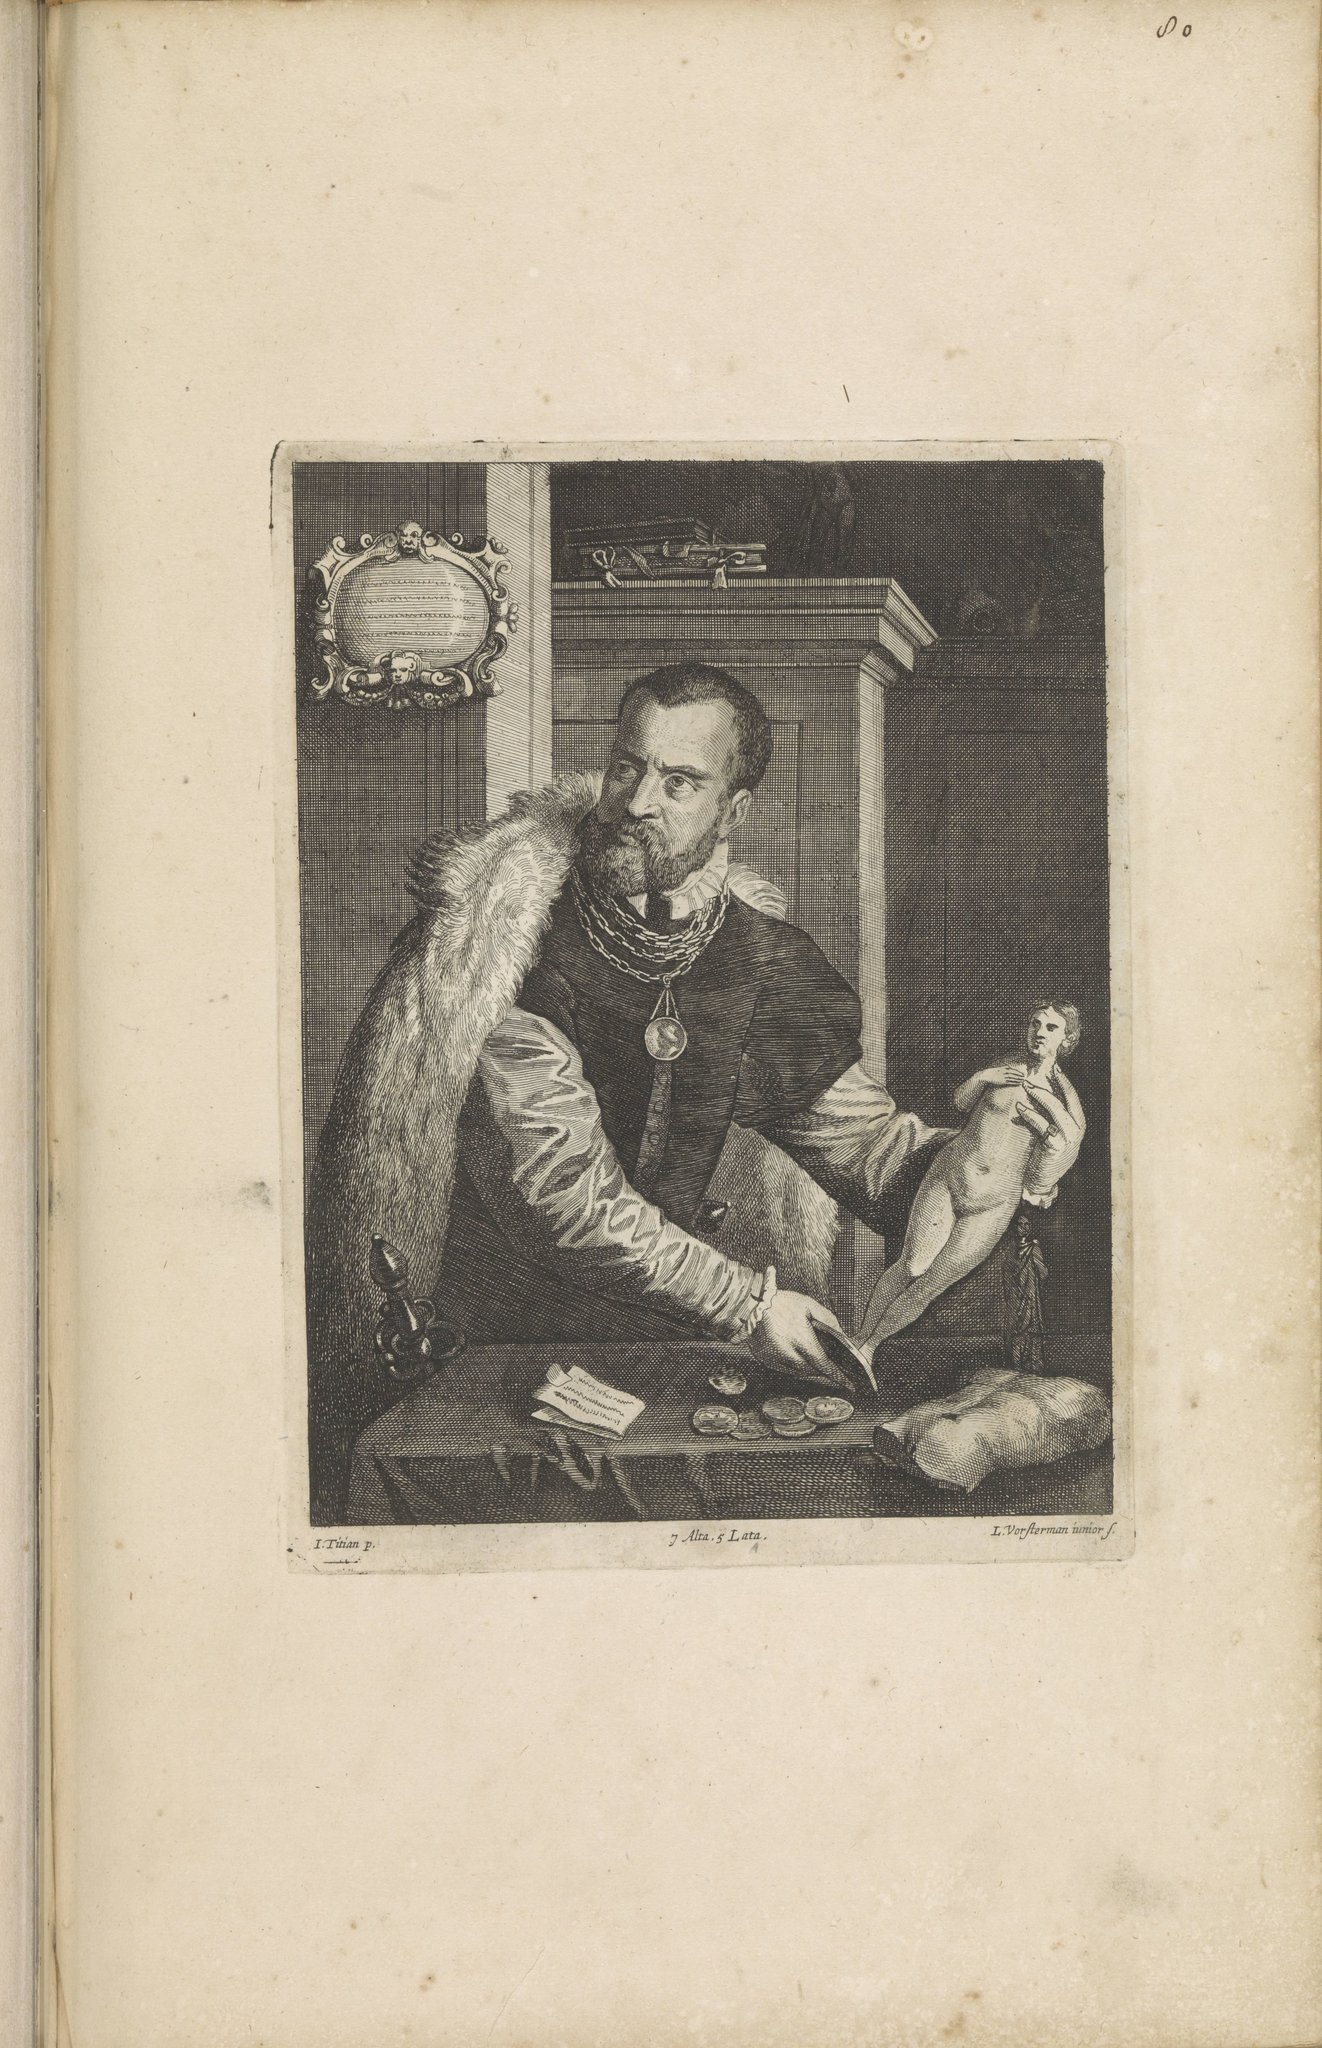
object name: print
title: Portret van Jacopo Strada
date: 1660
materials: paper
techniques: engraving, etching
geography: southern netherlands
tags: vienna, draughtsman, goldsmith, historical persons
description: De prent is vervaardigd naar het schilderij van Titiaan dat zich in de collectie van het Kunsthistorisches Museum te Wenen bevindt (inventarisnummer GG_81). David Teniers heeft waarschijnlijk van alle schilderijen uit de collectie van Leopold Willem van Oostenrijk een olieverfstudie op doek of paneel vervaardigd (zgn. pasticcio), die als voorbeeld voor de prentmakers diende. Het is niet altijd duidelijk of de pasticci door hem zijn gemaakt of door zijn atelier. Niet alle pasticci zijn overgeleverd.